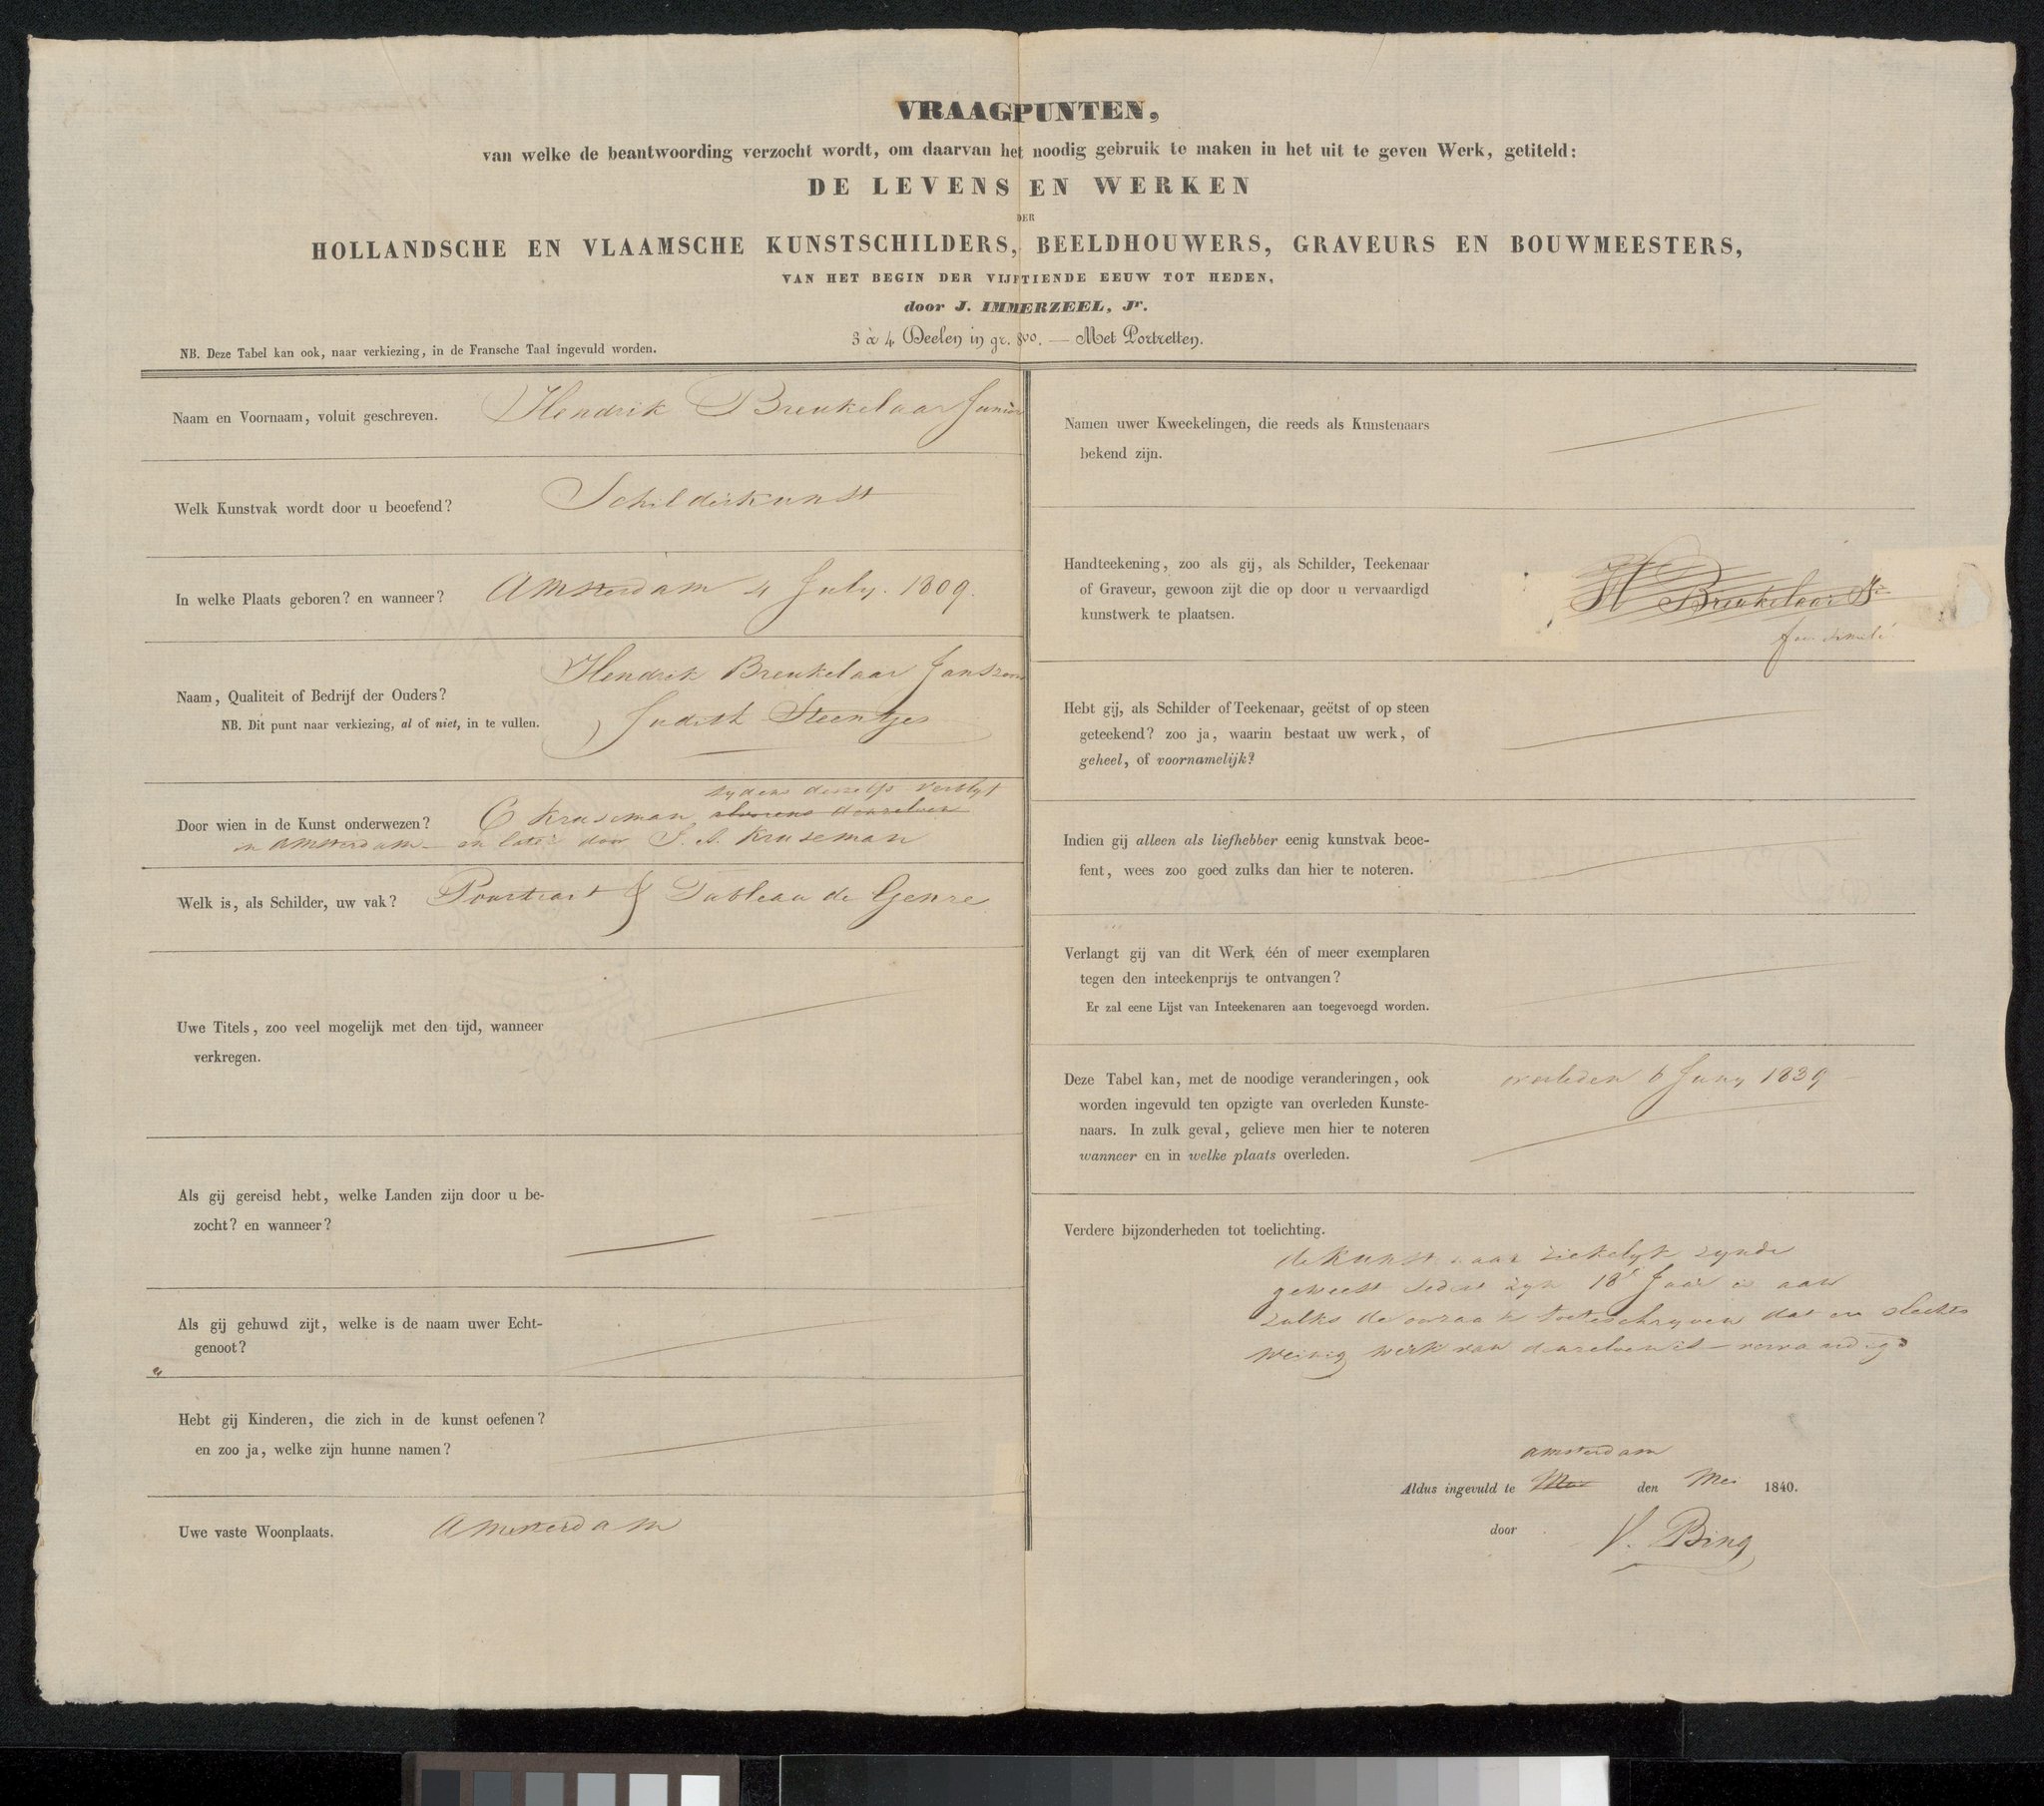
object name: questionnaire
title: Enquêteformulier betreffende Hendrik Breukelaar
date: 1805-1840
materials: ink, paper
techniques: pen, printing, writing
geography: amsterdam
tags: amsterdam, painter, draughtsman, hendrik breukelaar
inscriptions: inscription: ‘Vraagpunten,/ van welke de beantwoording verzocht wordt, om daarvan het noodig gebruik te maken in het uit te geven Werk, getiteld: De levens en werken/ der Hollandsche en Vlaamsche kunstschilders, beeldhouwers,/ graveurs en bouwmeesters, van het begin der vijftiende eeuw tot heden/ door J. Immerzeel, Jr.’, watermark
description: Opgenomen in: Immerzeel, J. Jr., De levens en werken der Hollandsche en Vlaamsche kunstschilders, beeldhouwers, graveurs en bouwmeesters, van het begin der vijftiende eeuw tot heden, Amsterdam: J.C. van Kesteren, 1842-1843.